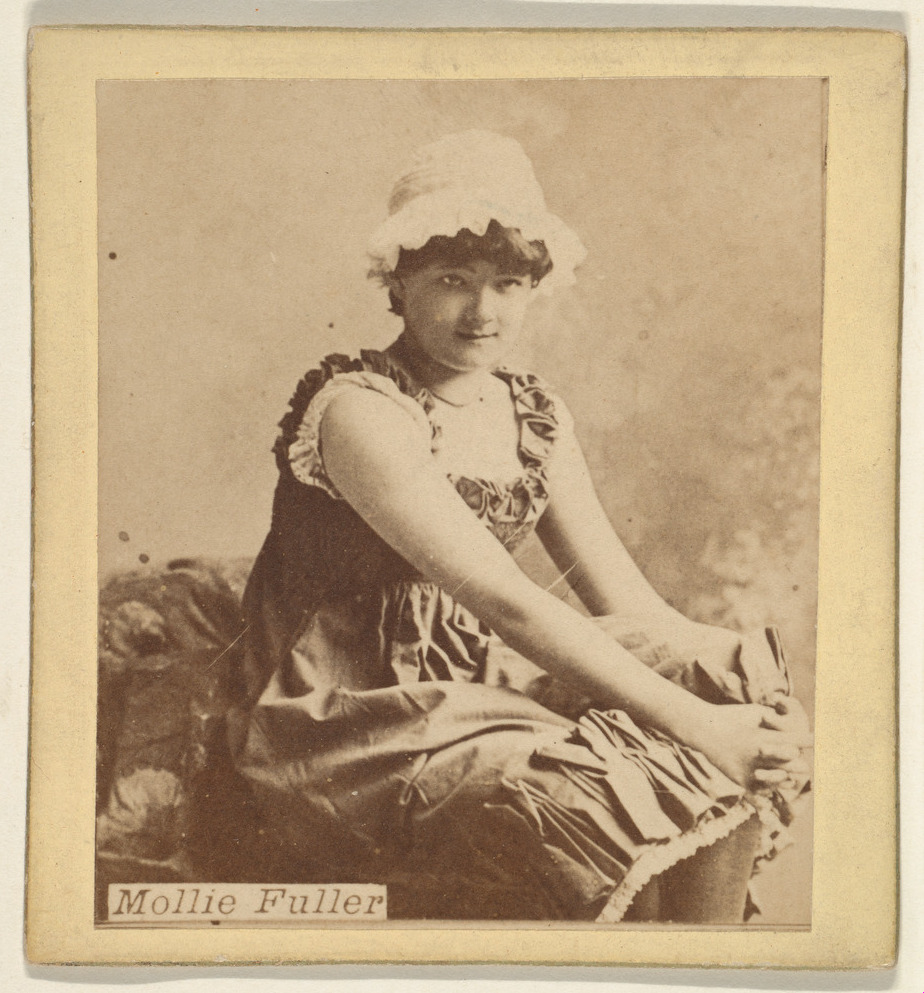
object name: photograph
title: Mollie Fuller, from the Actresses series (N246), Type 2, issued by Kinney Brothers to promote Sporting Extra Cigarettes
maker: kinney brothers tobacco company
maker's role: publisher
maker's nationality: american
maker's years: 1869-2011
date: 1890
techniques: albumen silver print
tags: portraits,women,actresses